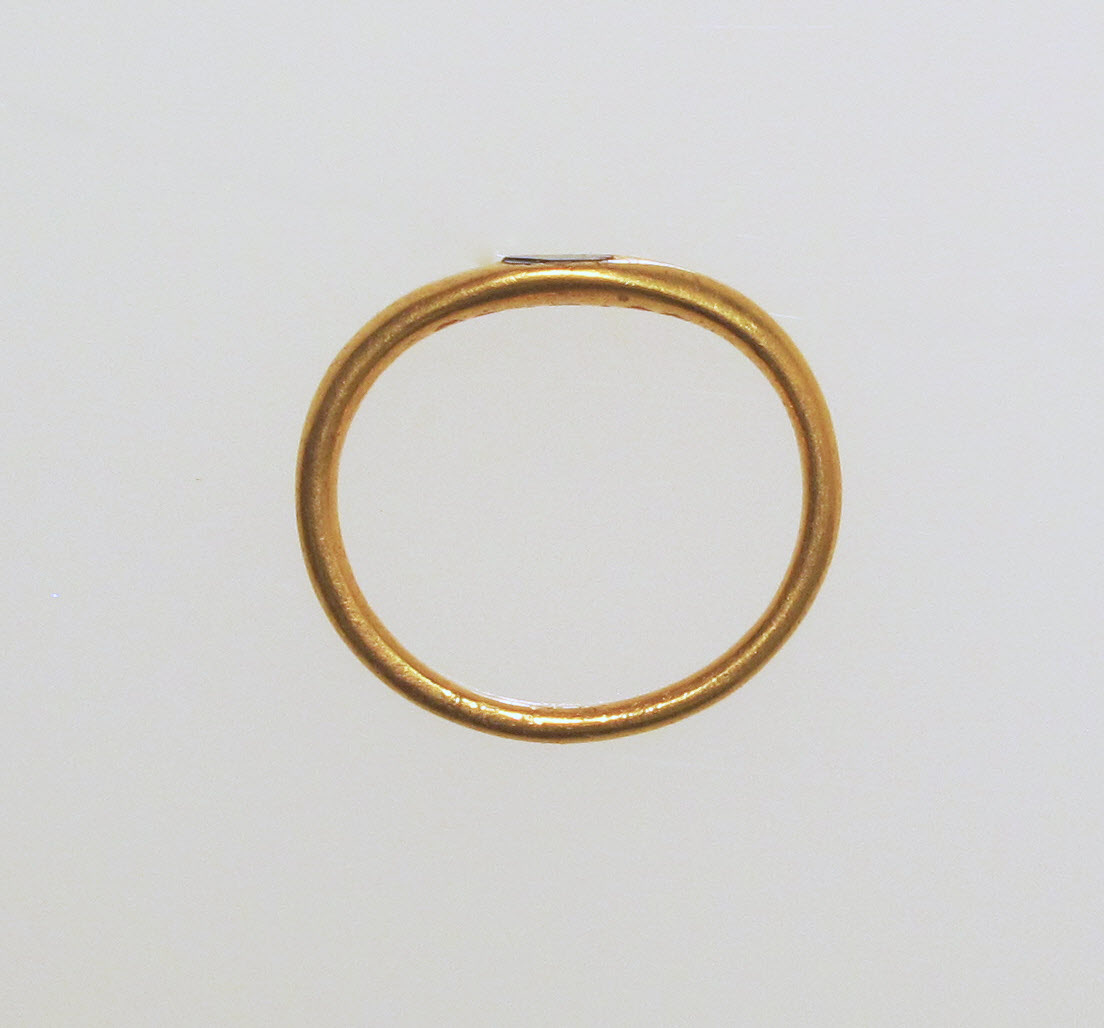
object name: ring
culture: roman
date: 670 BCE-330 CE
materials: gold